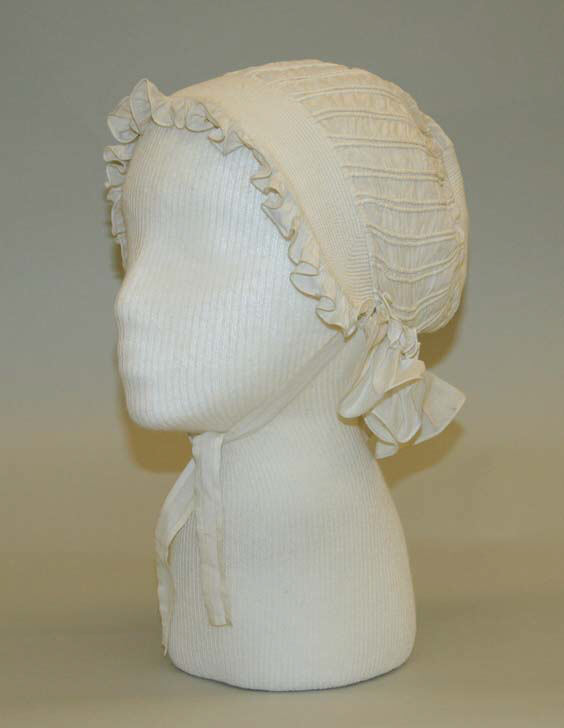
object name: bonnet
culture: american or european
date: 1799-1815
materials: cotton